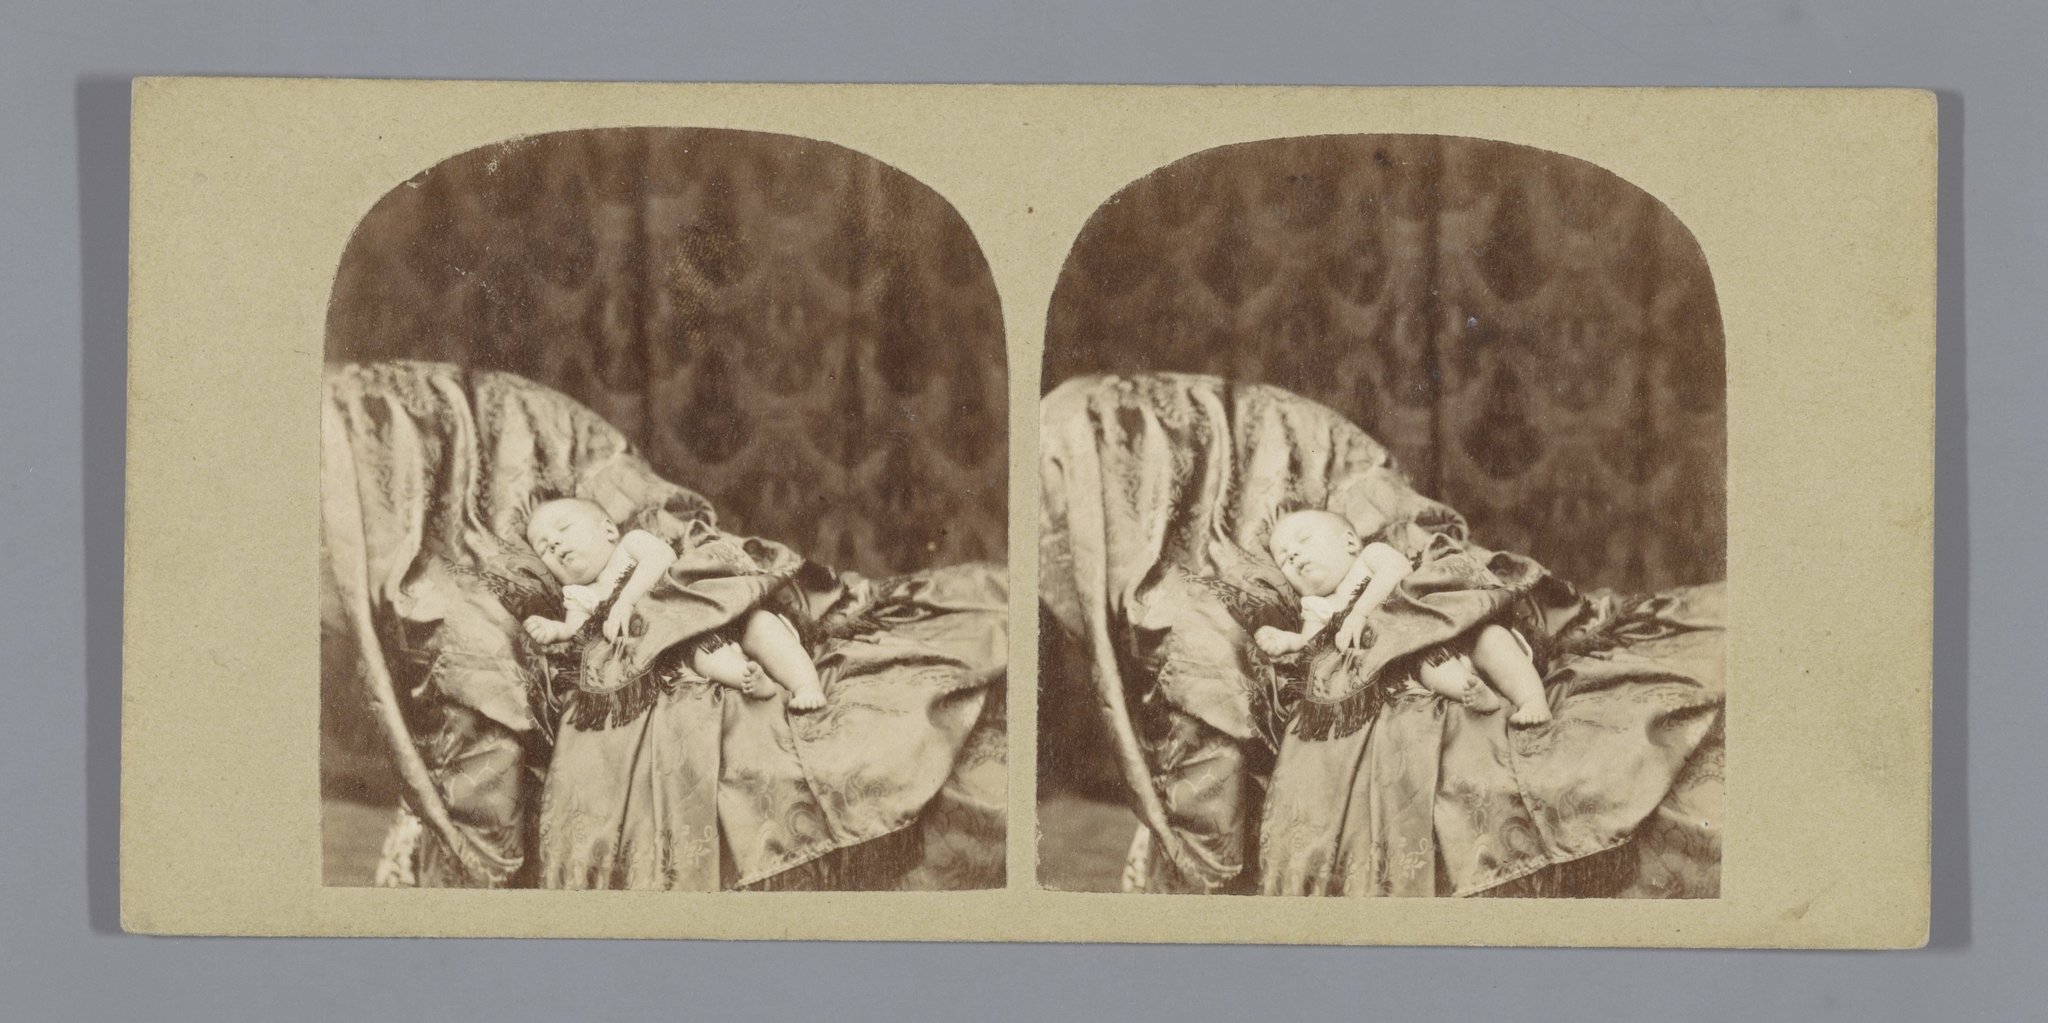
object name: stereograph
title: Portret van een onbekende, slapende baby op een stoel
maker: Anonymous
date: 1850-1880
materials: cardboard, photographic support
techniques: albumen print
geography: europe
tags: sleeping; unconsciousness, infant, baby, europe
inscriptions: name: ‘Feldbrugge & Co Groningen’